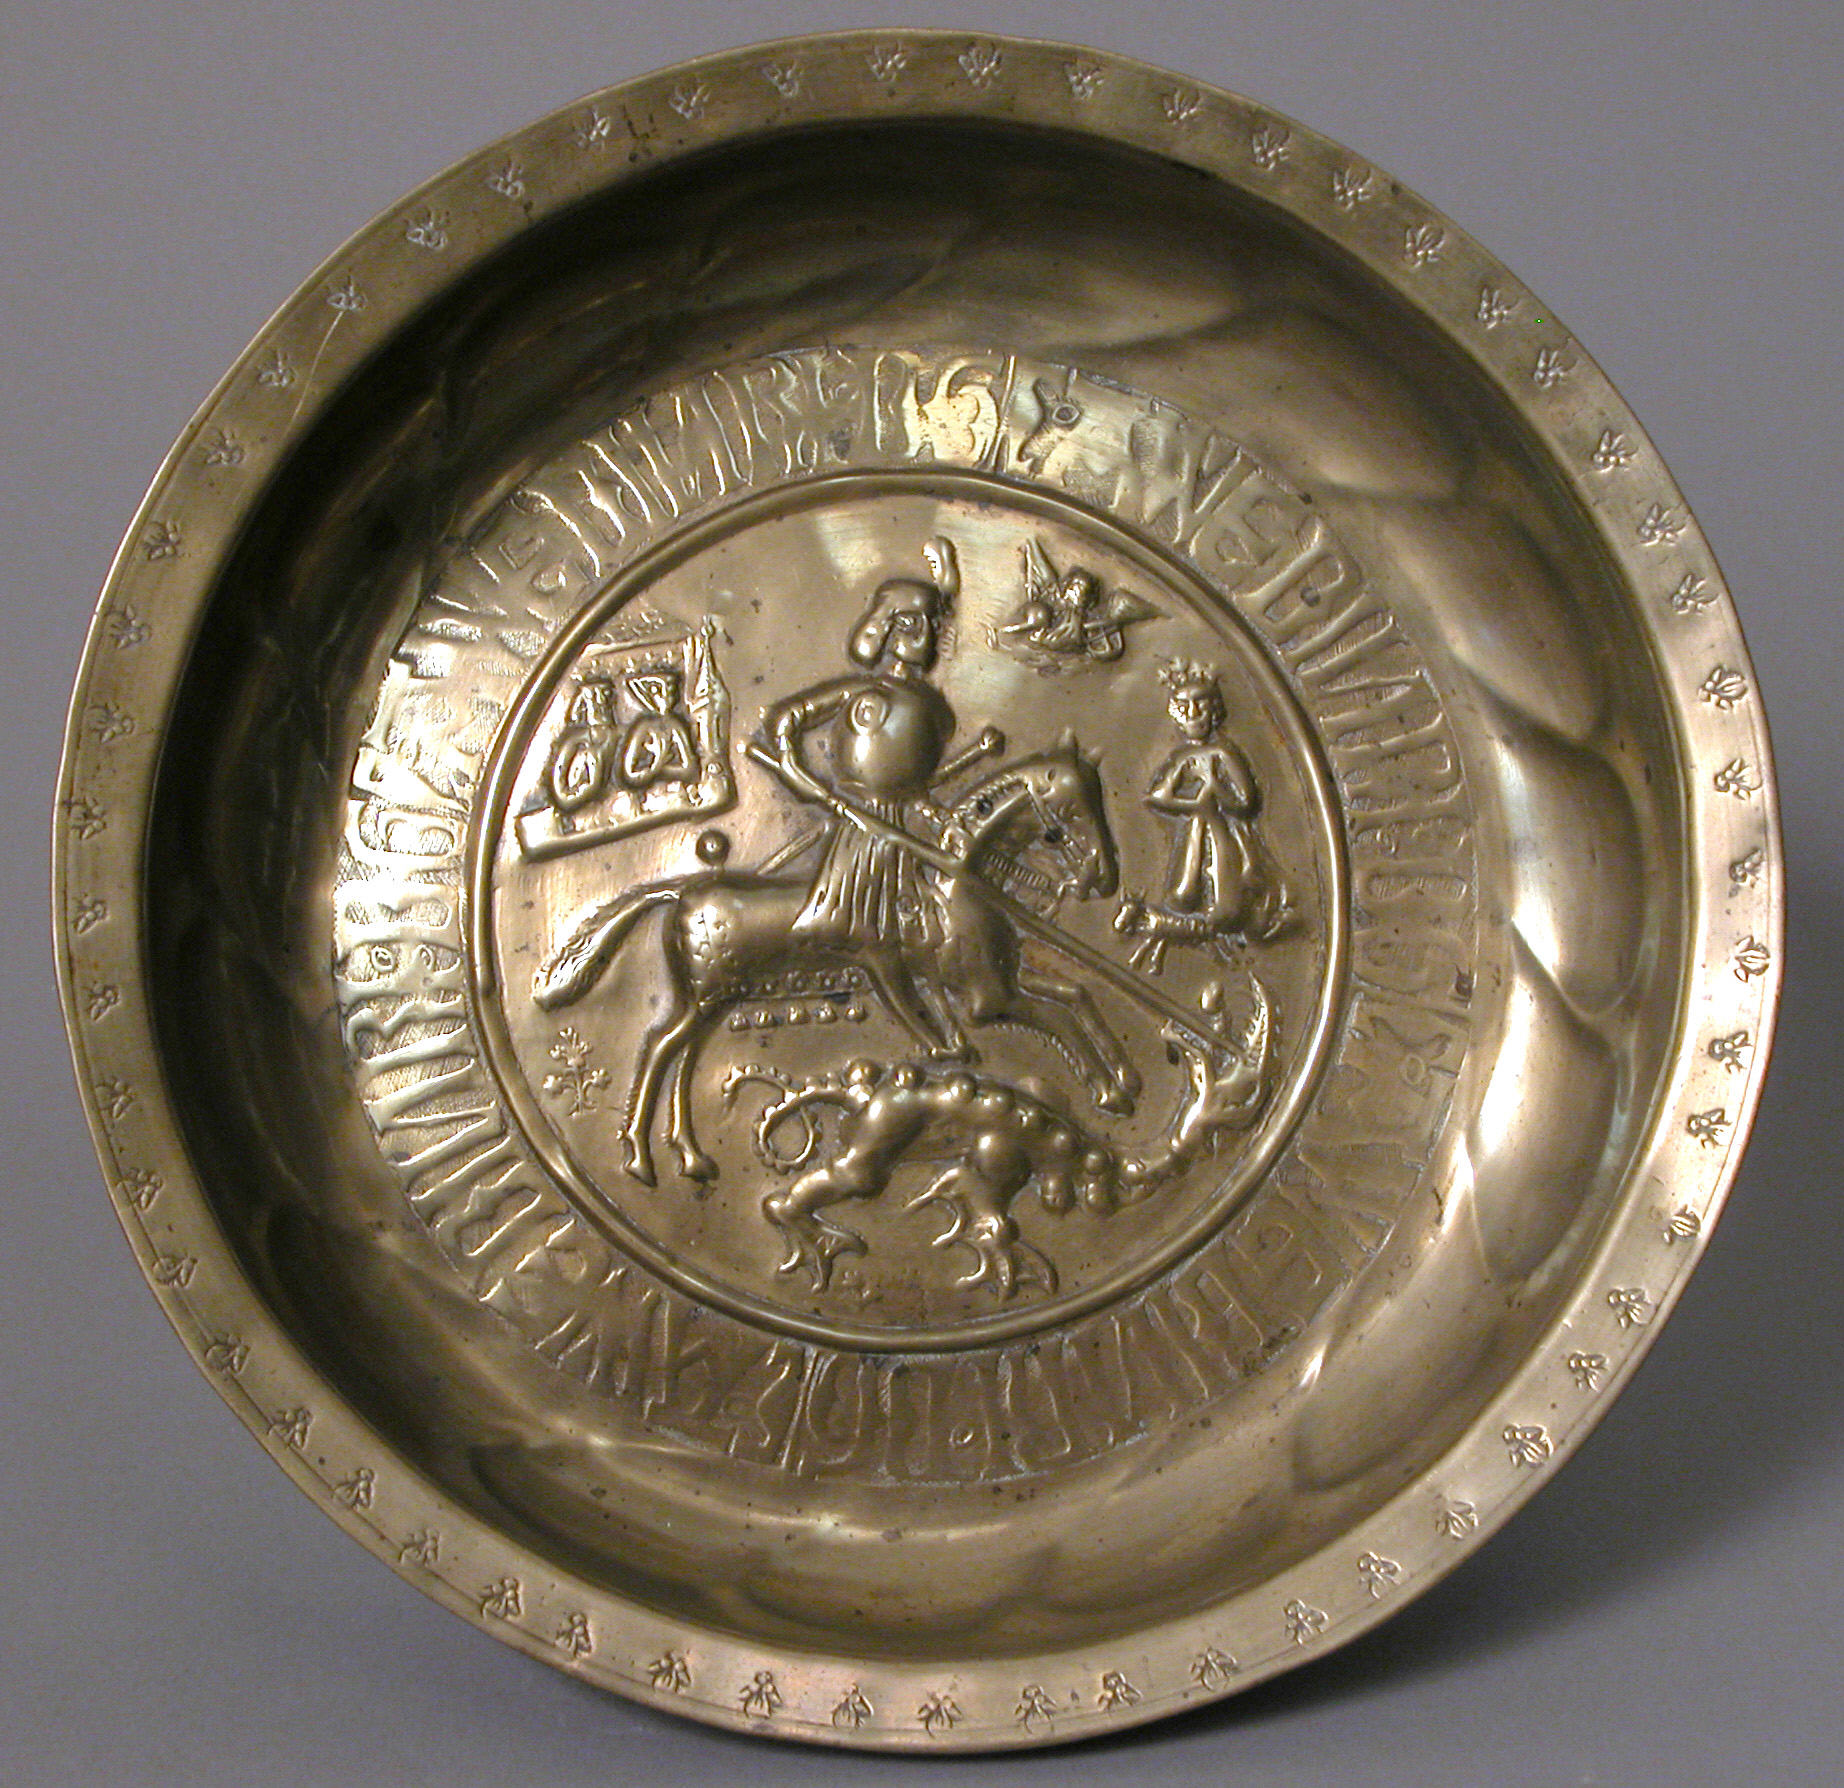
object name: bowl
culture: german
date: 1467-1500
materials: brass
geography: germany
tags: human figures,dragons,horses